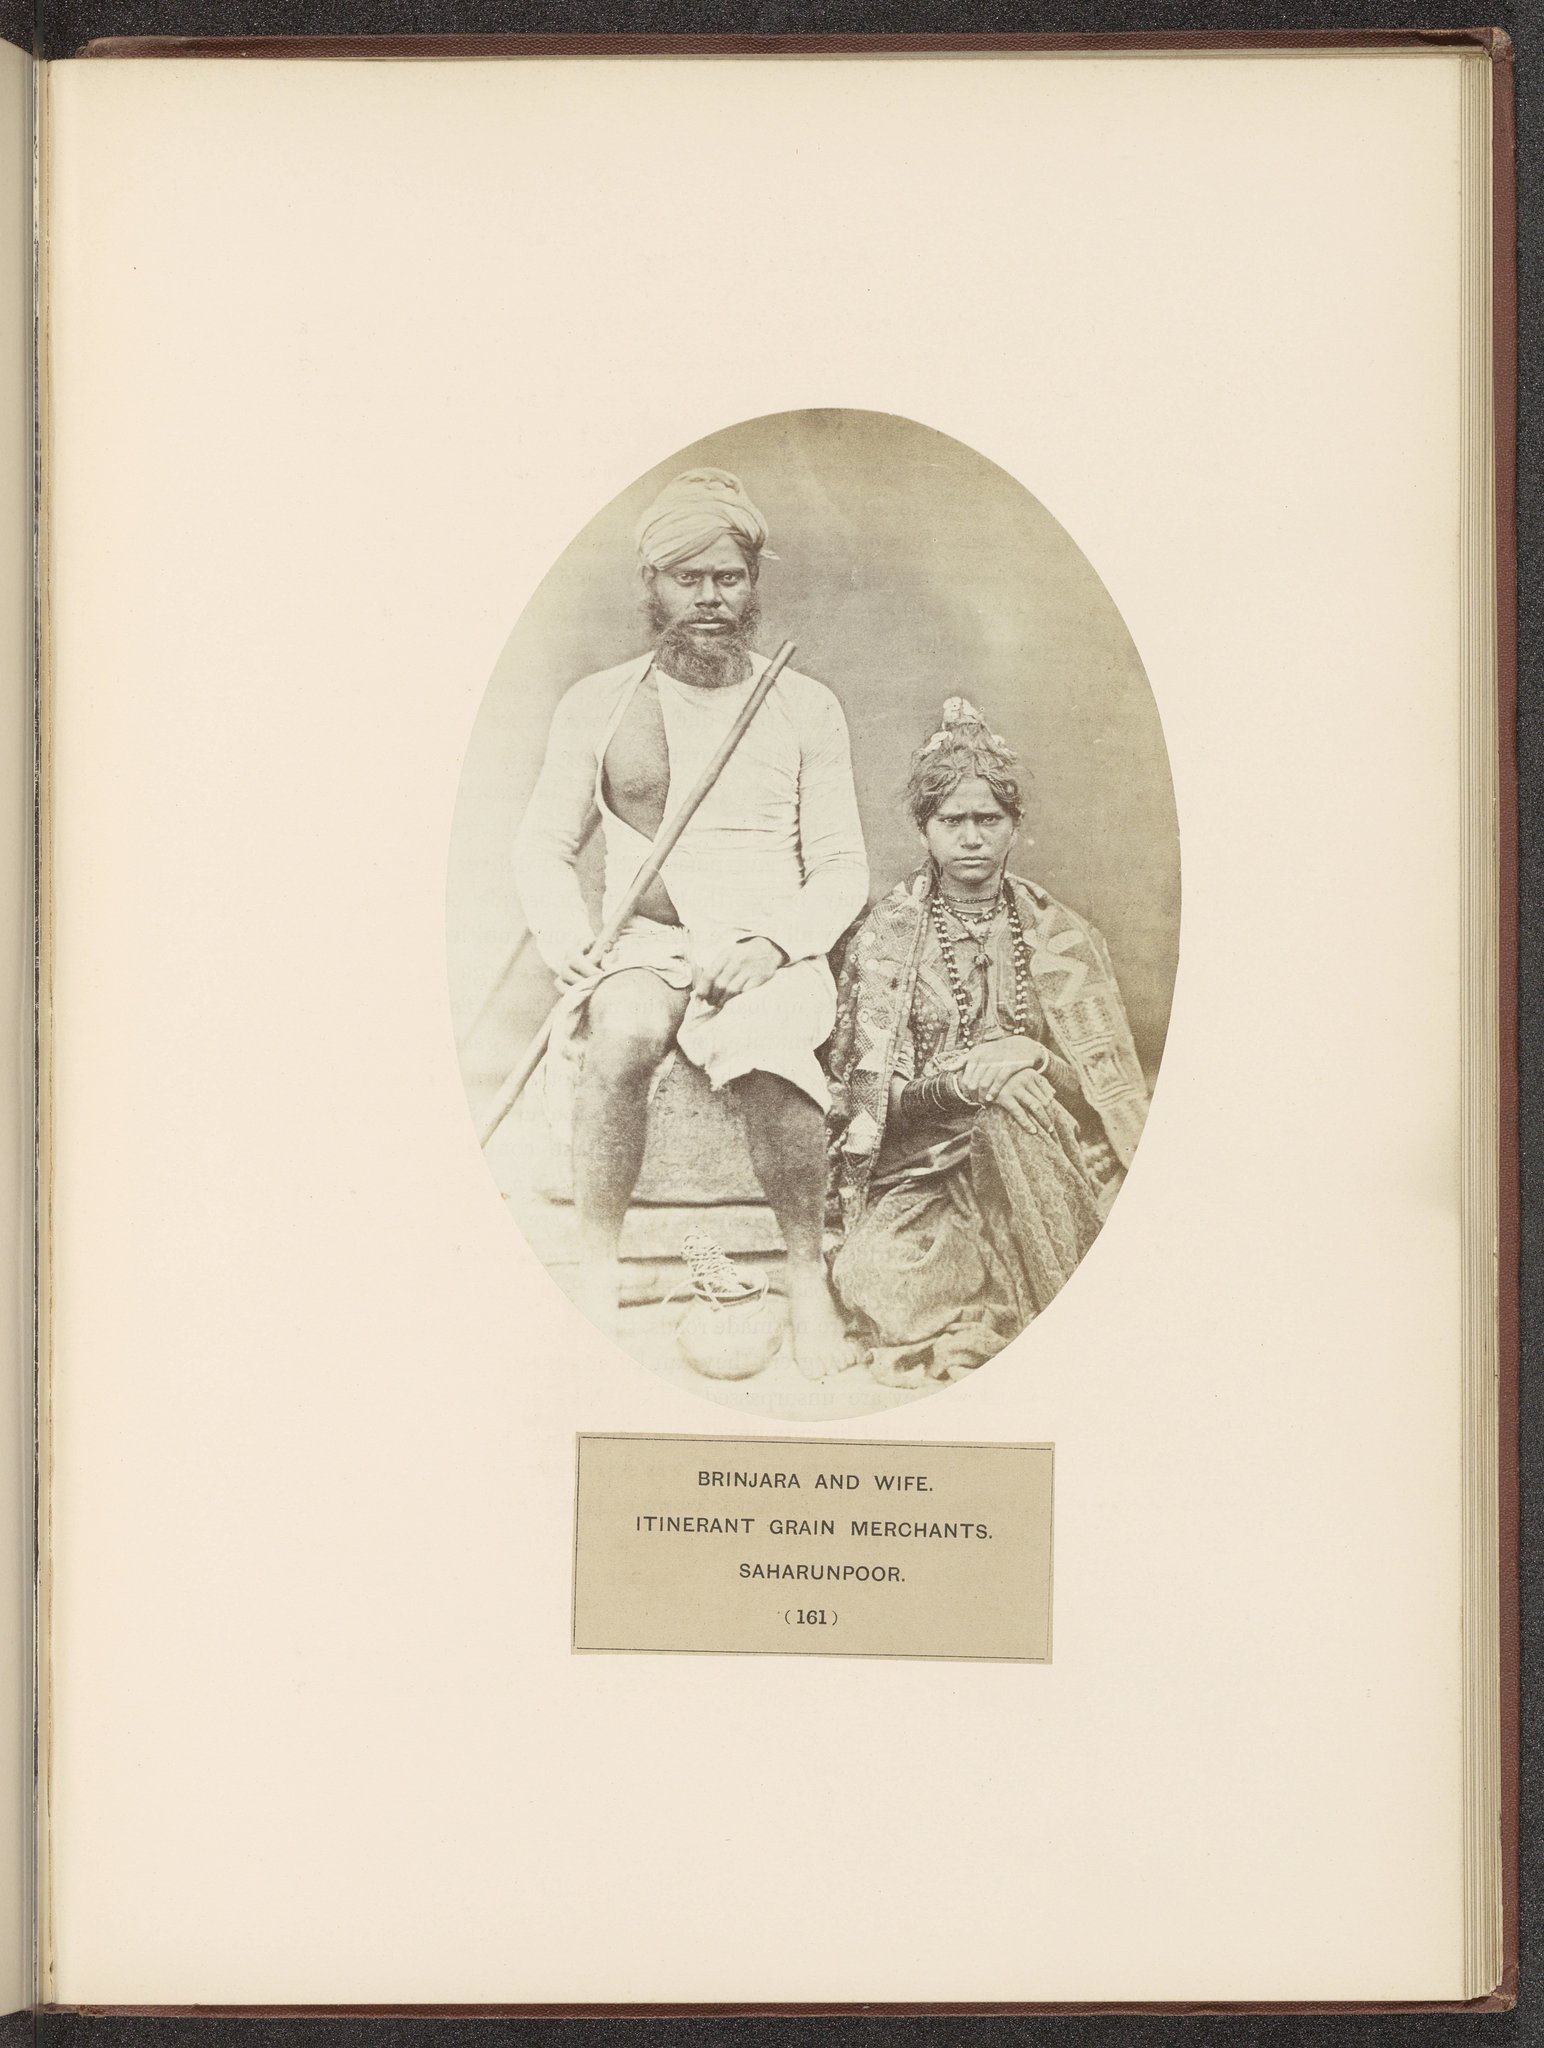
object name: page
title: Portrait of a nomadic grain merchant couple in Saharanpur, Uttar Pradesh, India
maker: Anonymous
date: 1858-1868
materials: photographic support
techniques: albumen print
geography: saharanpur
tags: human races; peoples; nationalities, merchant, salesman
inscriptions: inscription: ‘BRINJARA AND WIFE./ ITINERANT GRAIN MERCHANTS./ SAHARUNPOOR.’, number: ‘(161)’